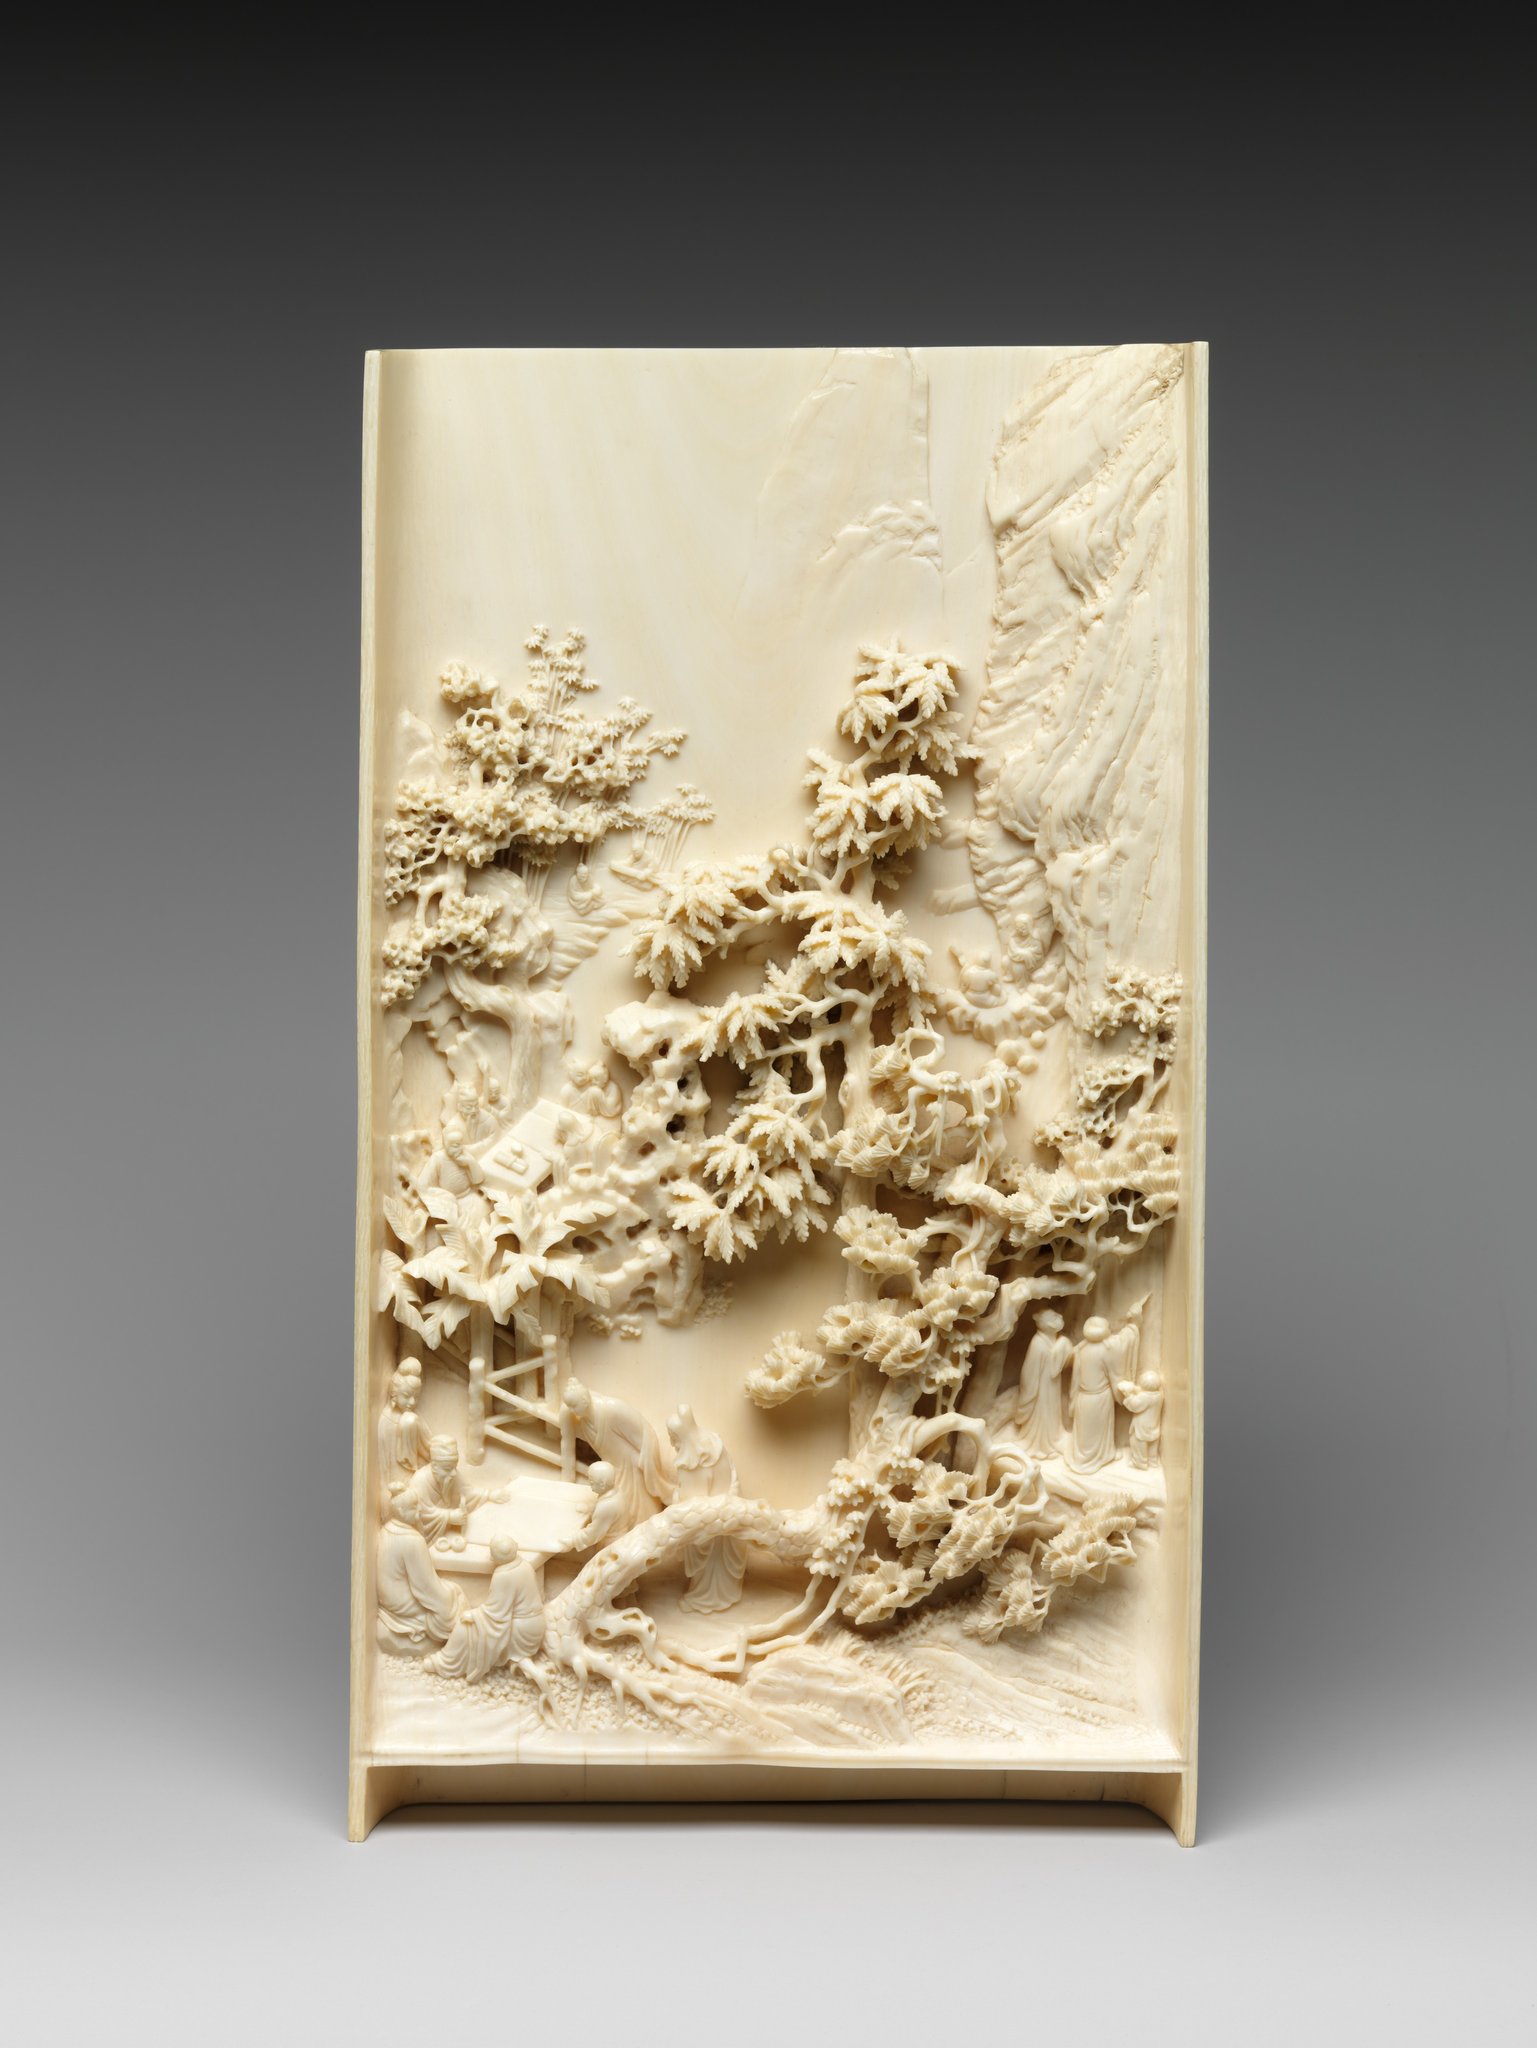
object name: table screen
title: Table screen with the gathering in the Western Garden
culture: chinese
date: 1701-1800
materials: ivory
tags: trees